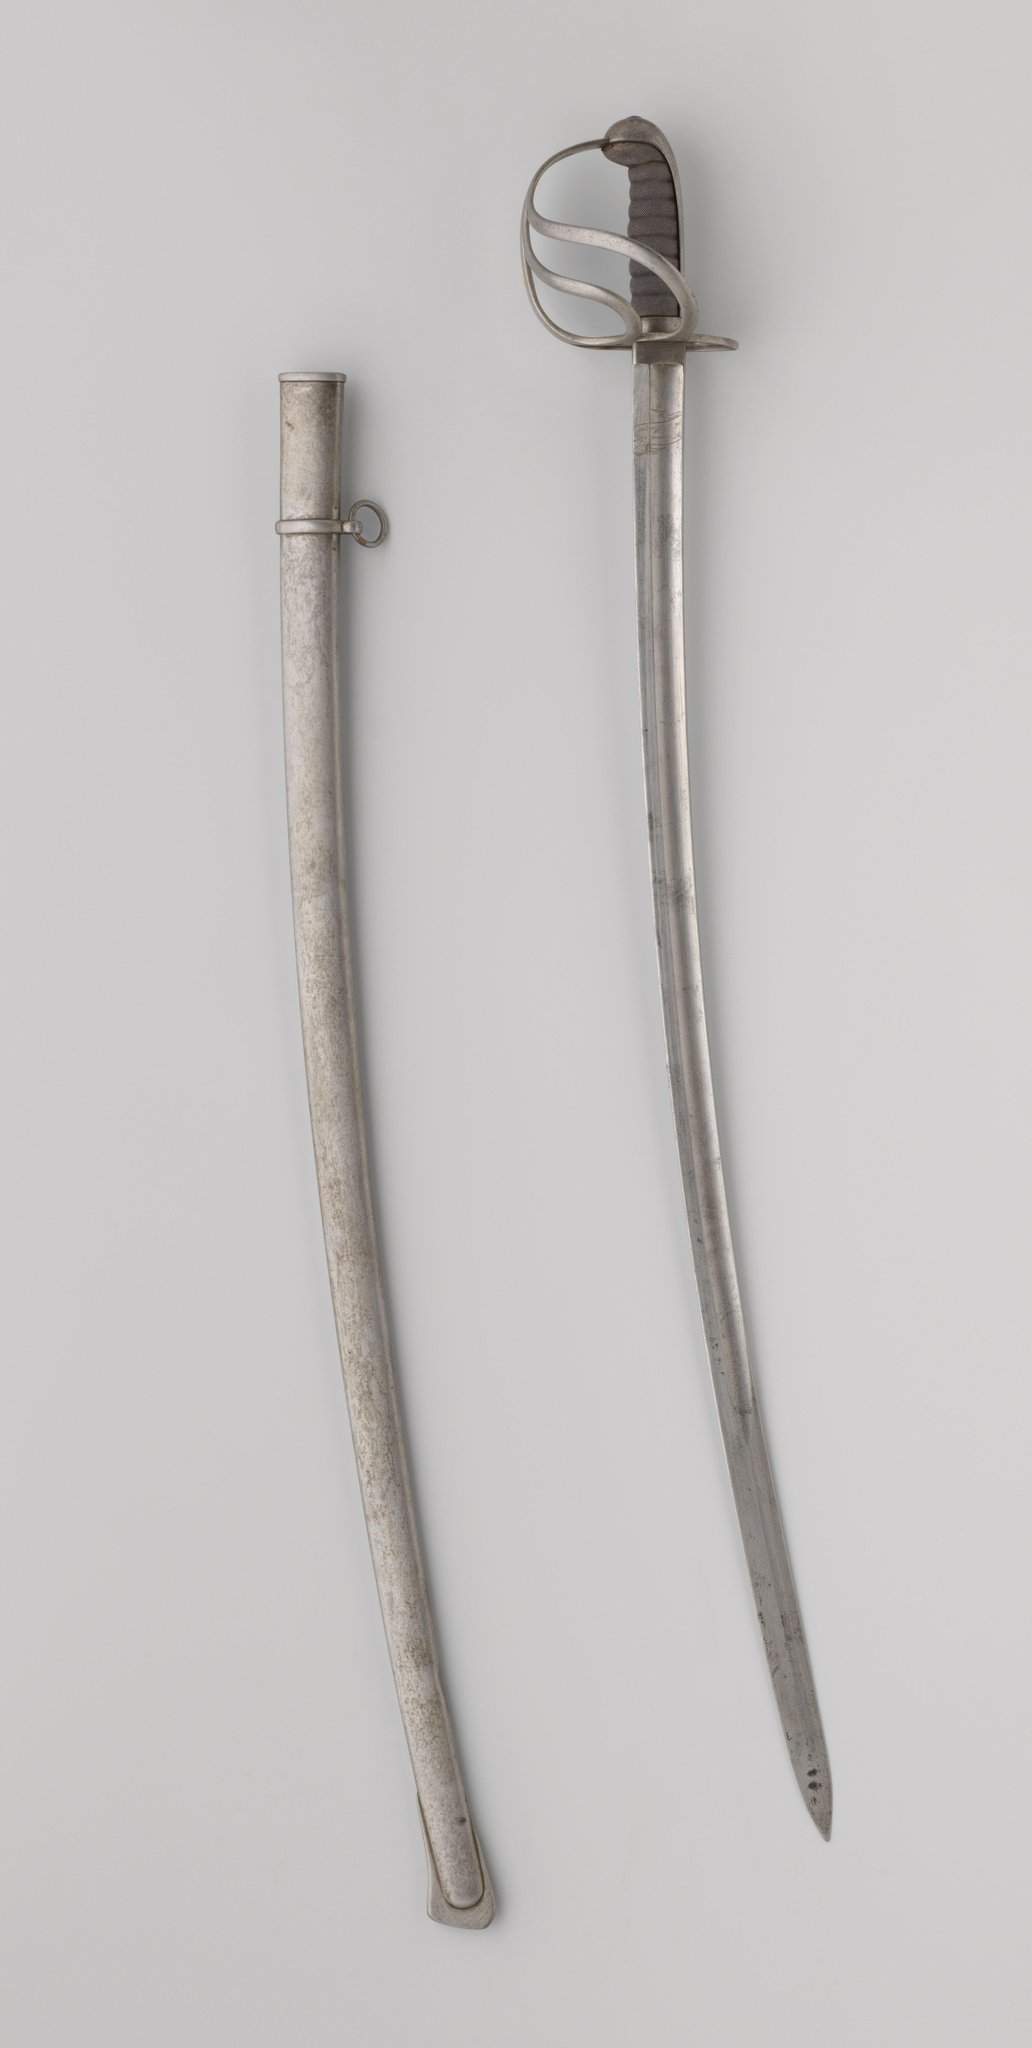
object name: sabre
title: Officierssabel der cavalerie M 1854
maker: Anonymous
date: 1854-1855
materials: iron, skin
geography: germany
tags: germany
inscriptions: mark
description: Cavaleriesabel voor officieren M 1854, model der generale staf (1 schedeband met losse ring). Op de kling het merk van de firma Neuhaus.